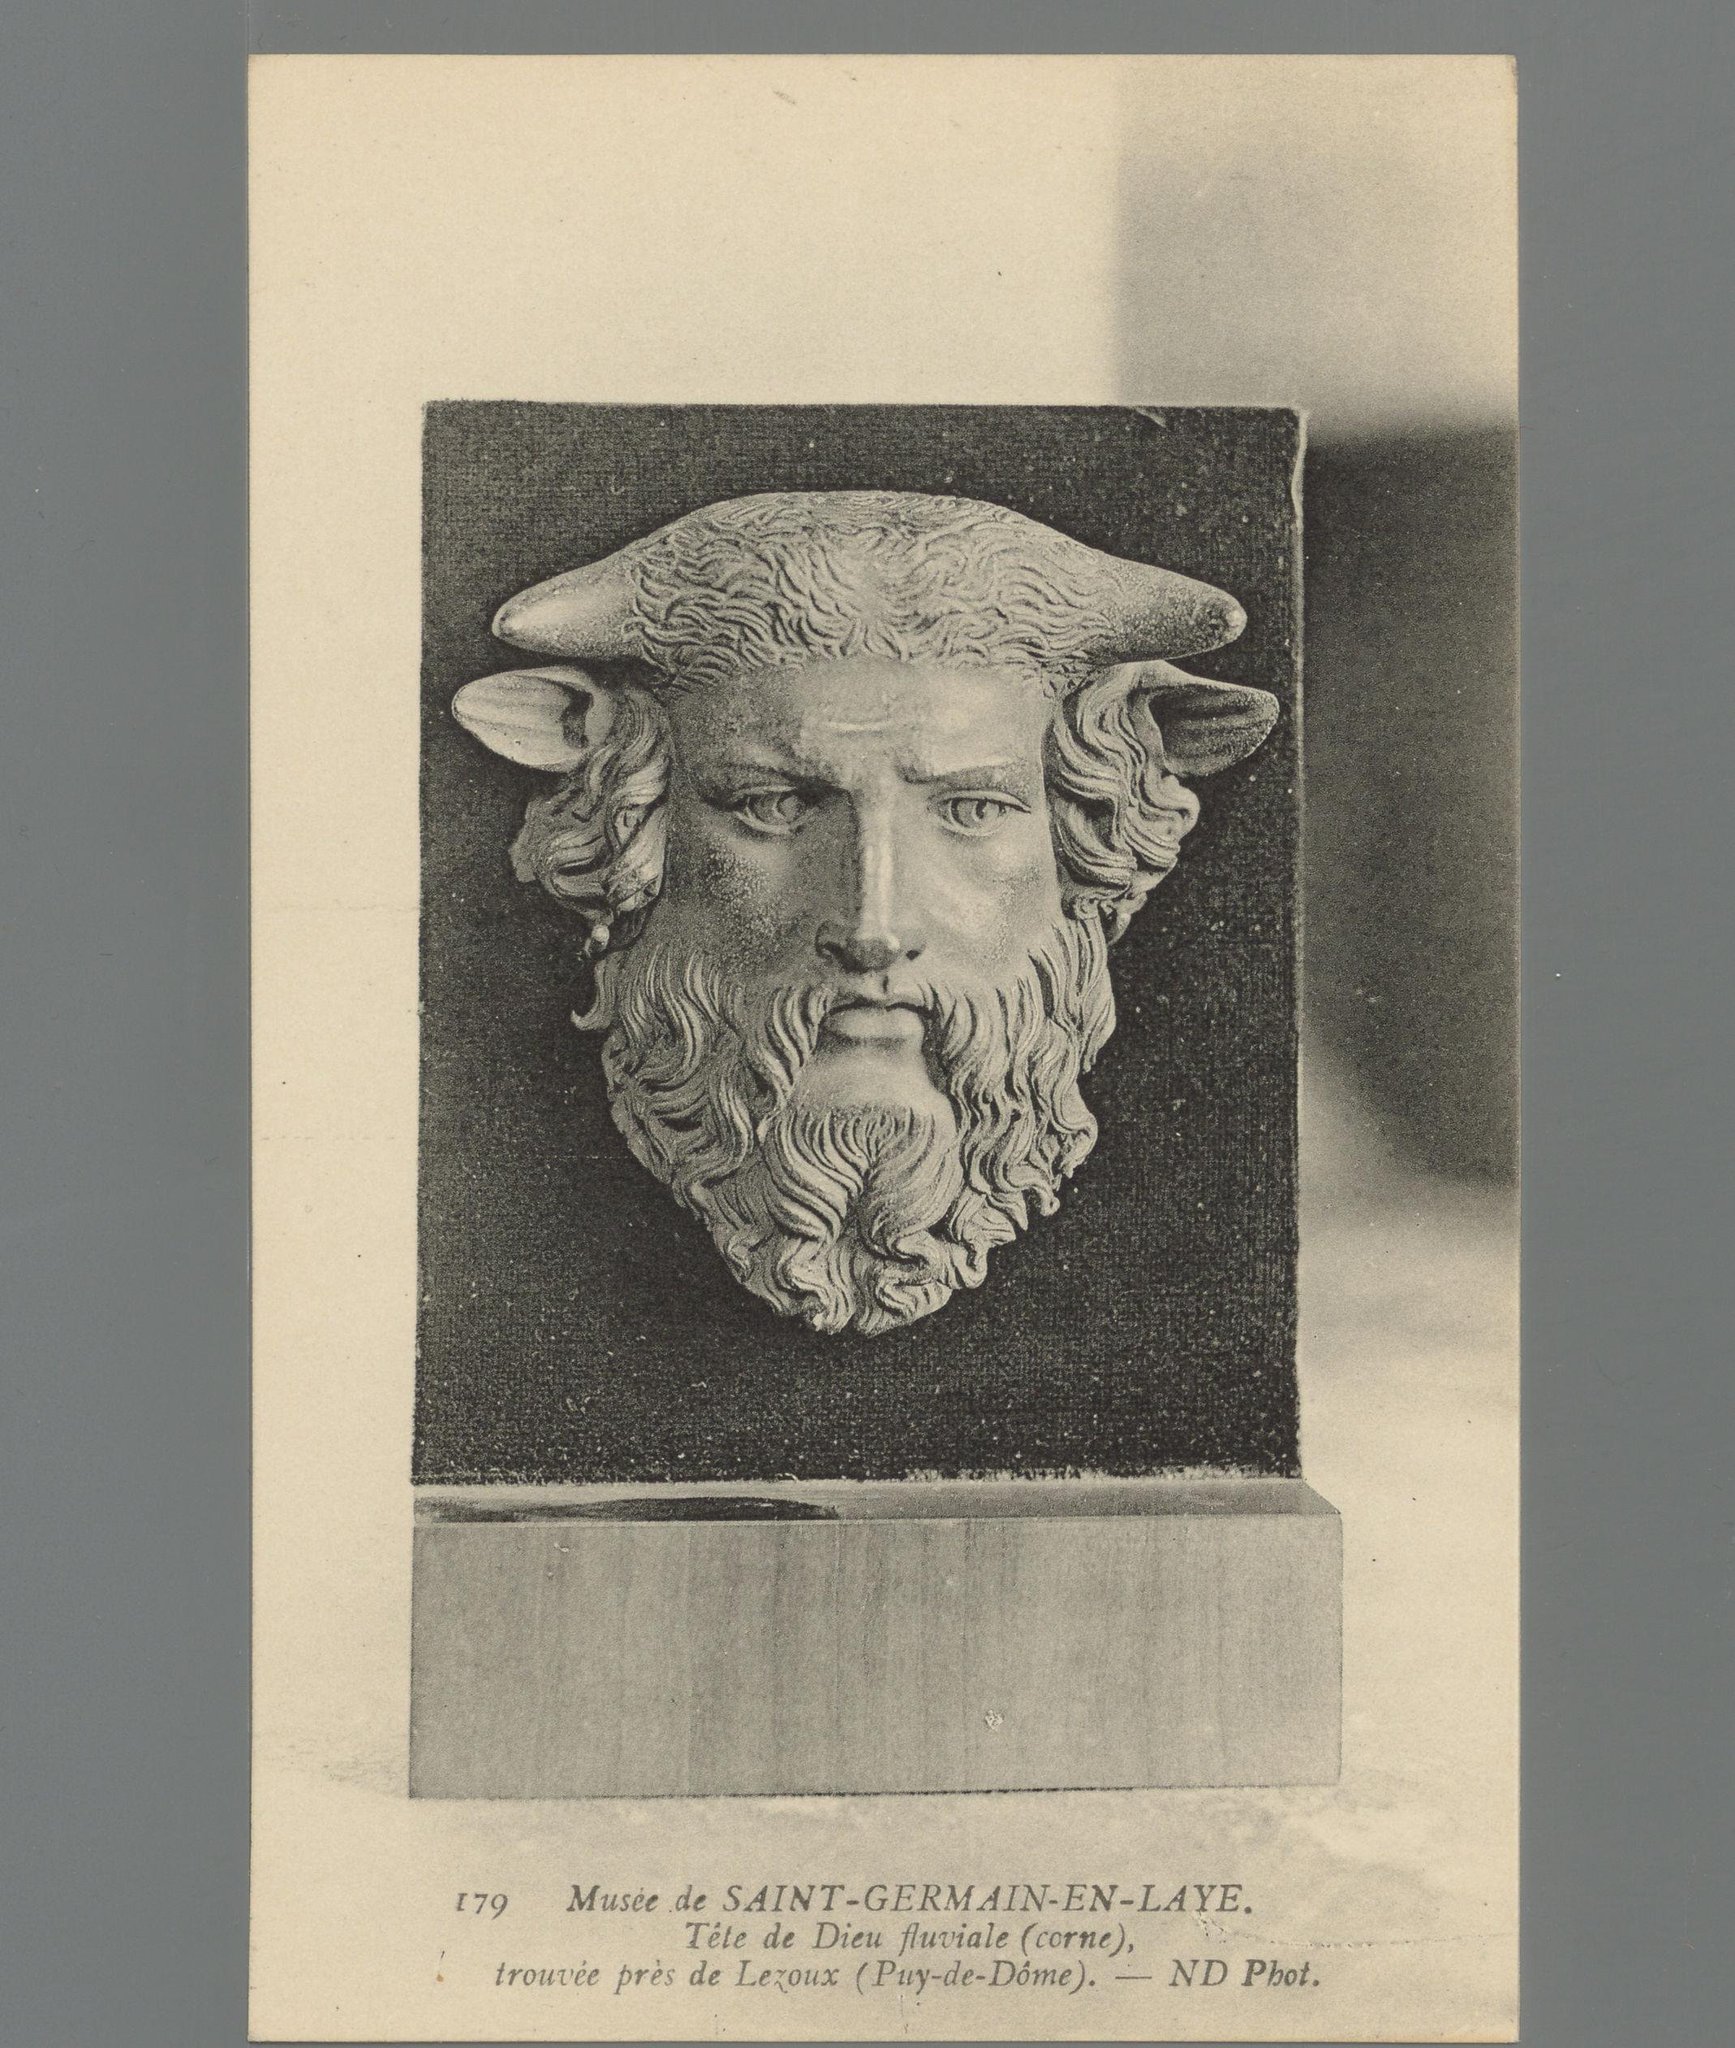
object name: ansichtkaart, prentbriefkaart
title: Tête de Dieu fluviale (corne), trouvée près de Lezoux (Puy-de-Dôme)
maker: Anonymous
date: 1903-1918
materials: cardboard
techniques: photograph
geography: paris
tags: permanent exhibition, museum, sculpture